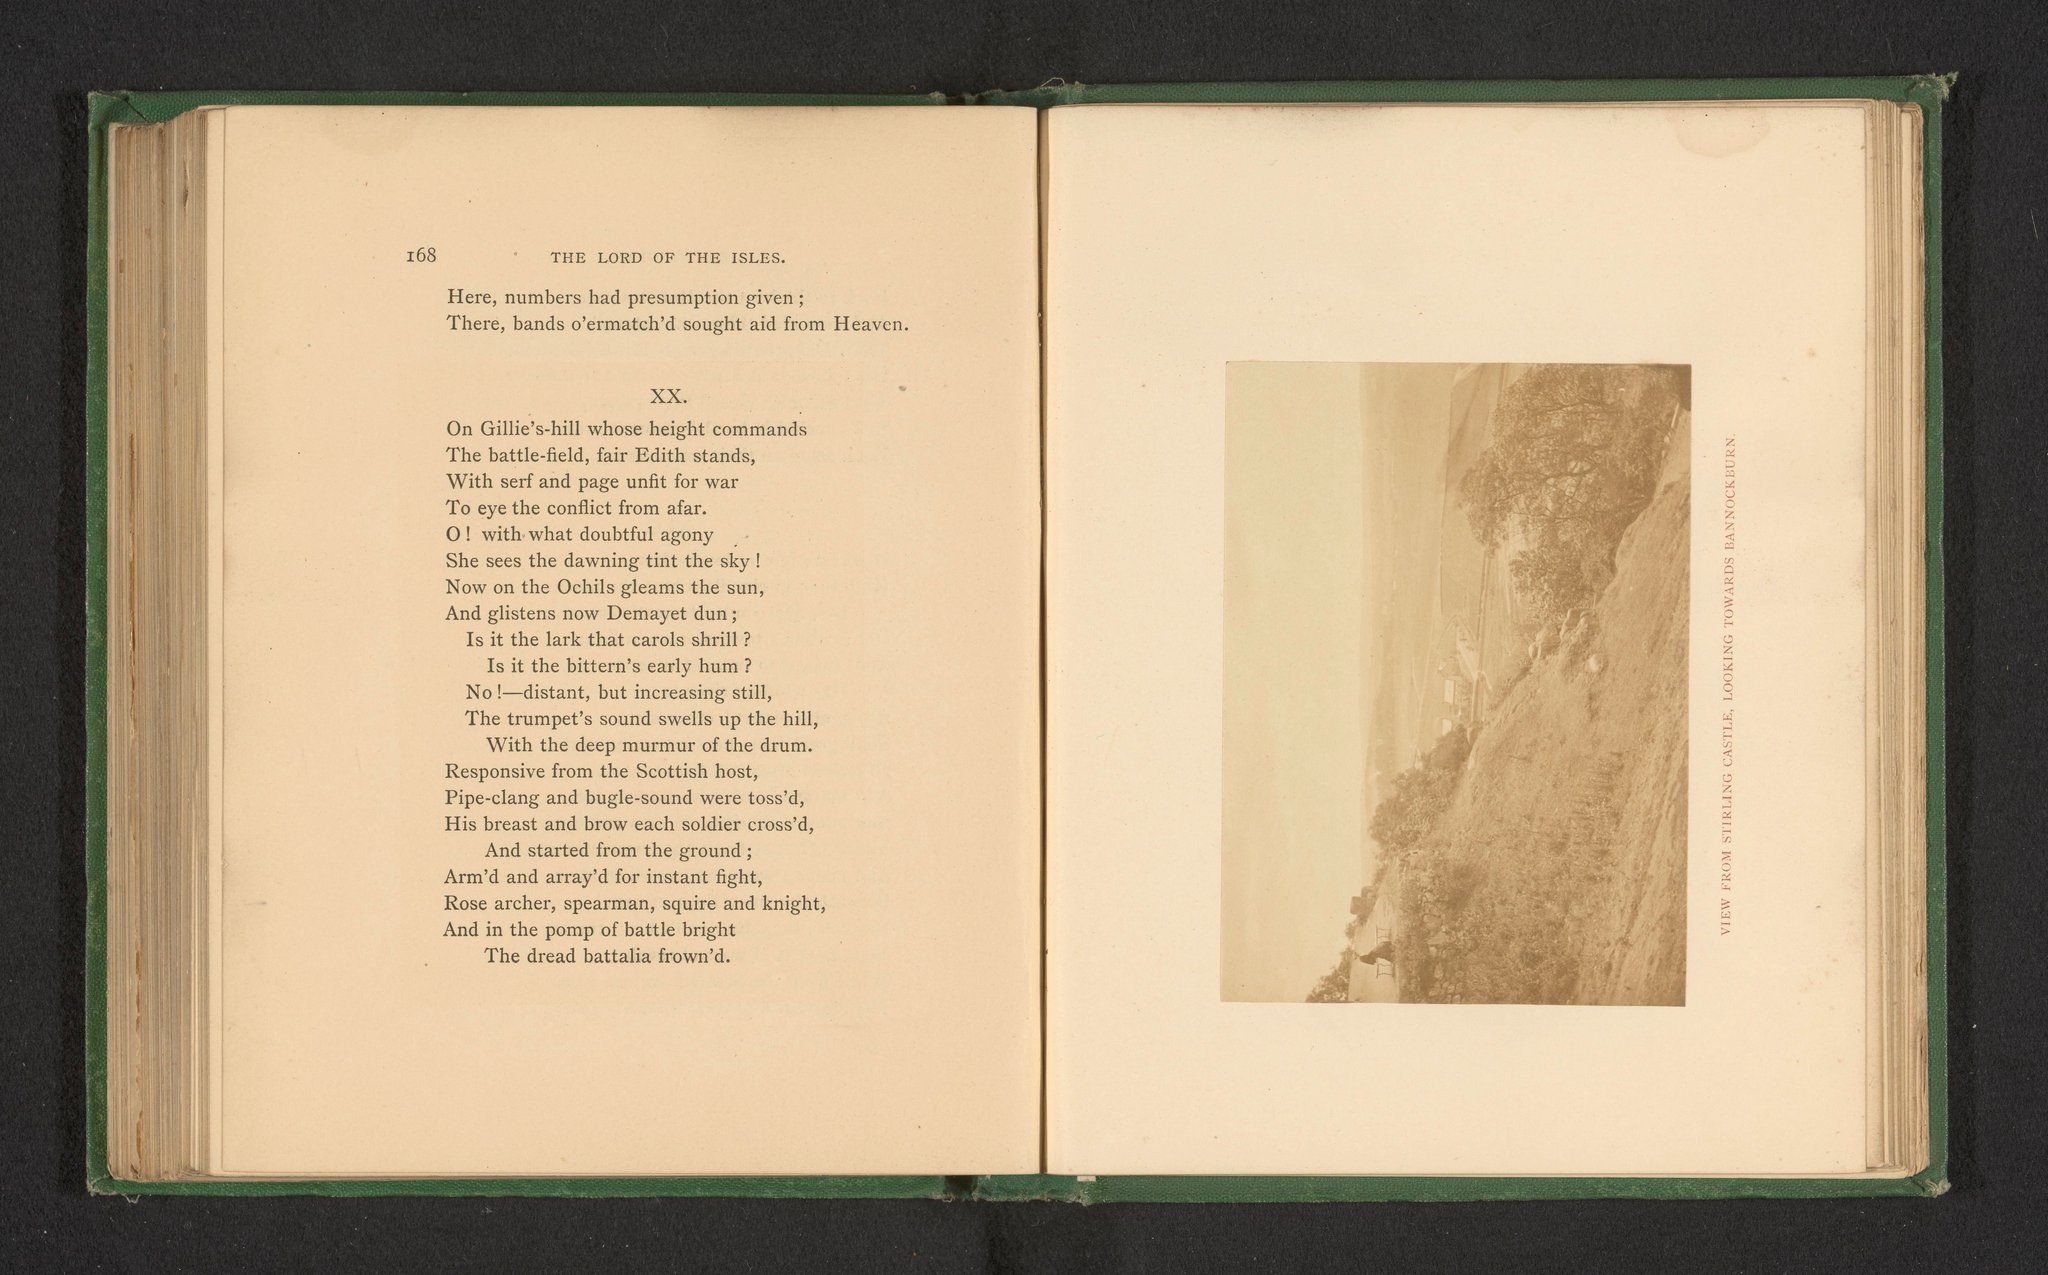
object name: page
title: View from Stirling Castle, looking towards Bannockburn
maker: william russell sedgfield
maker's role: fotograaf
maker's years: 1826-1902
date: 1861-1871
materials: photographic support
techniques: albumen print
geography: stirling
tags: dale, valley